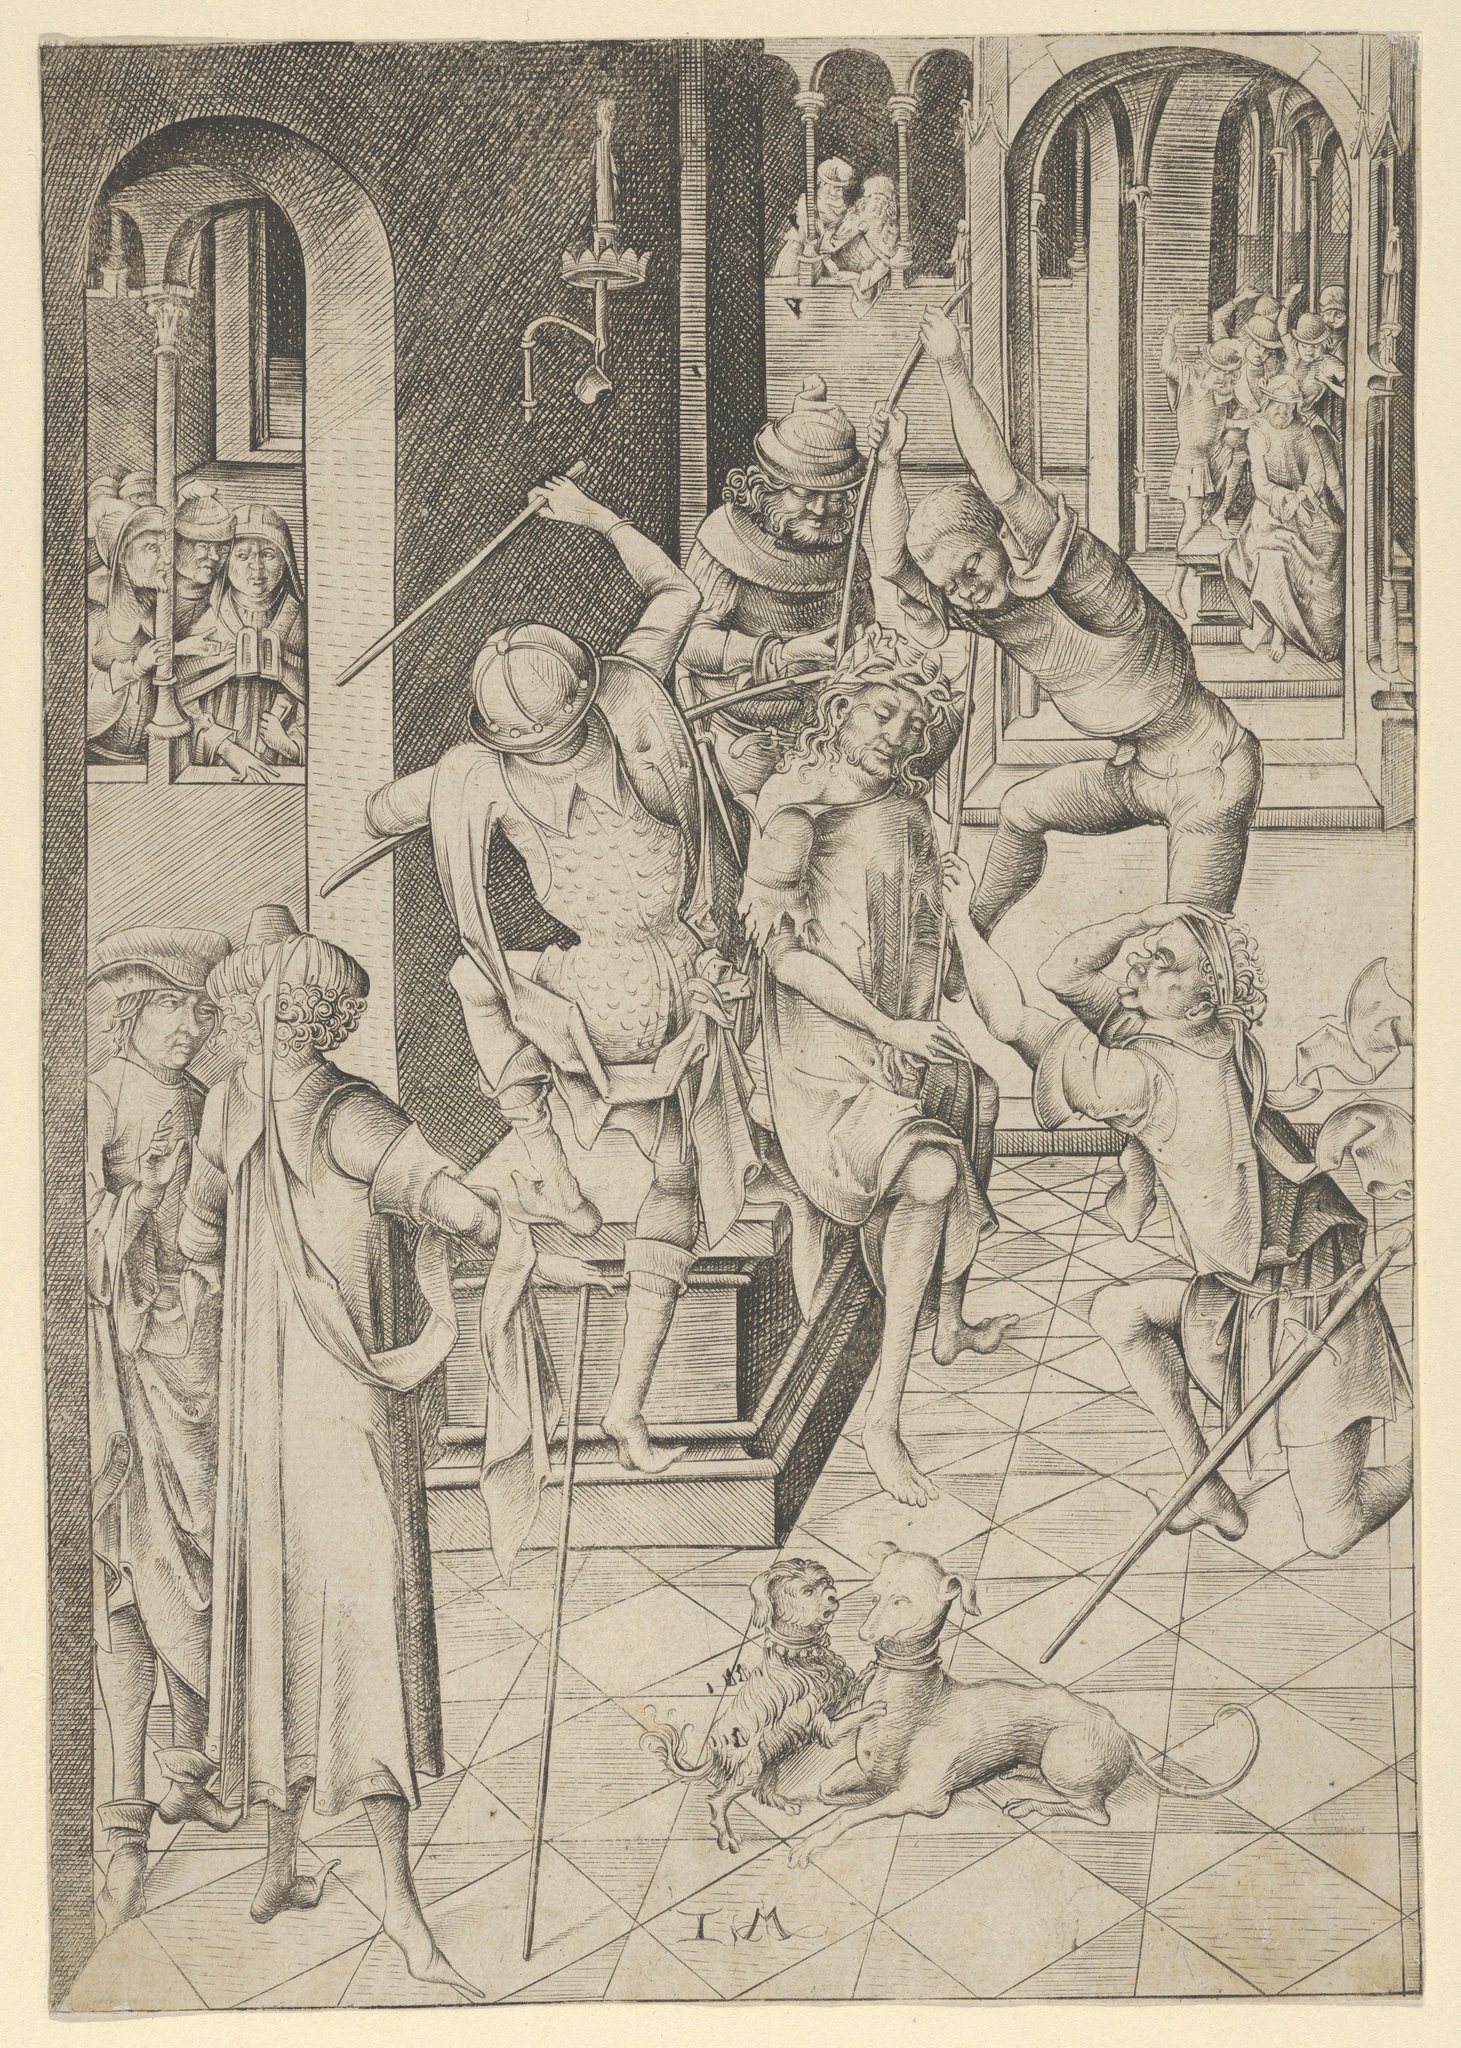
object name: print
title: Christ Crowned with Thorns from The Passion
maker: israhel van meckenem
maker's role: artist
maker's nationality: german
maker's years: 1435-1503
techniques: engraving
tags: interiors,weapons,suffering,men,dogs,christ,crowd